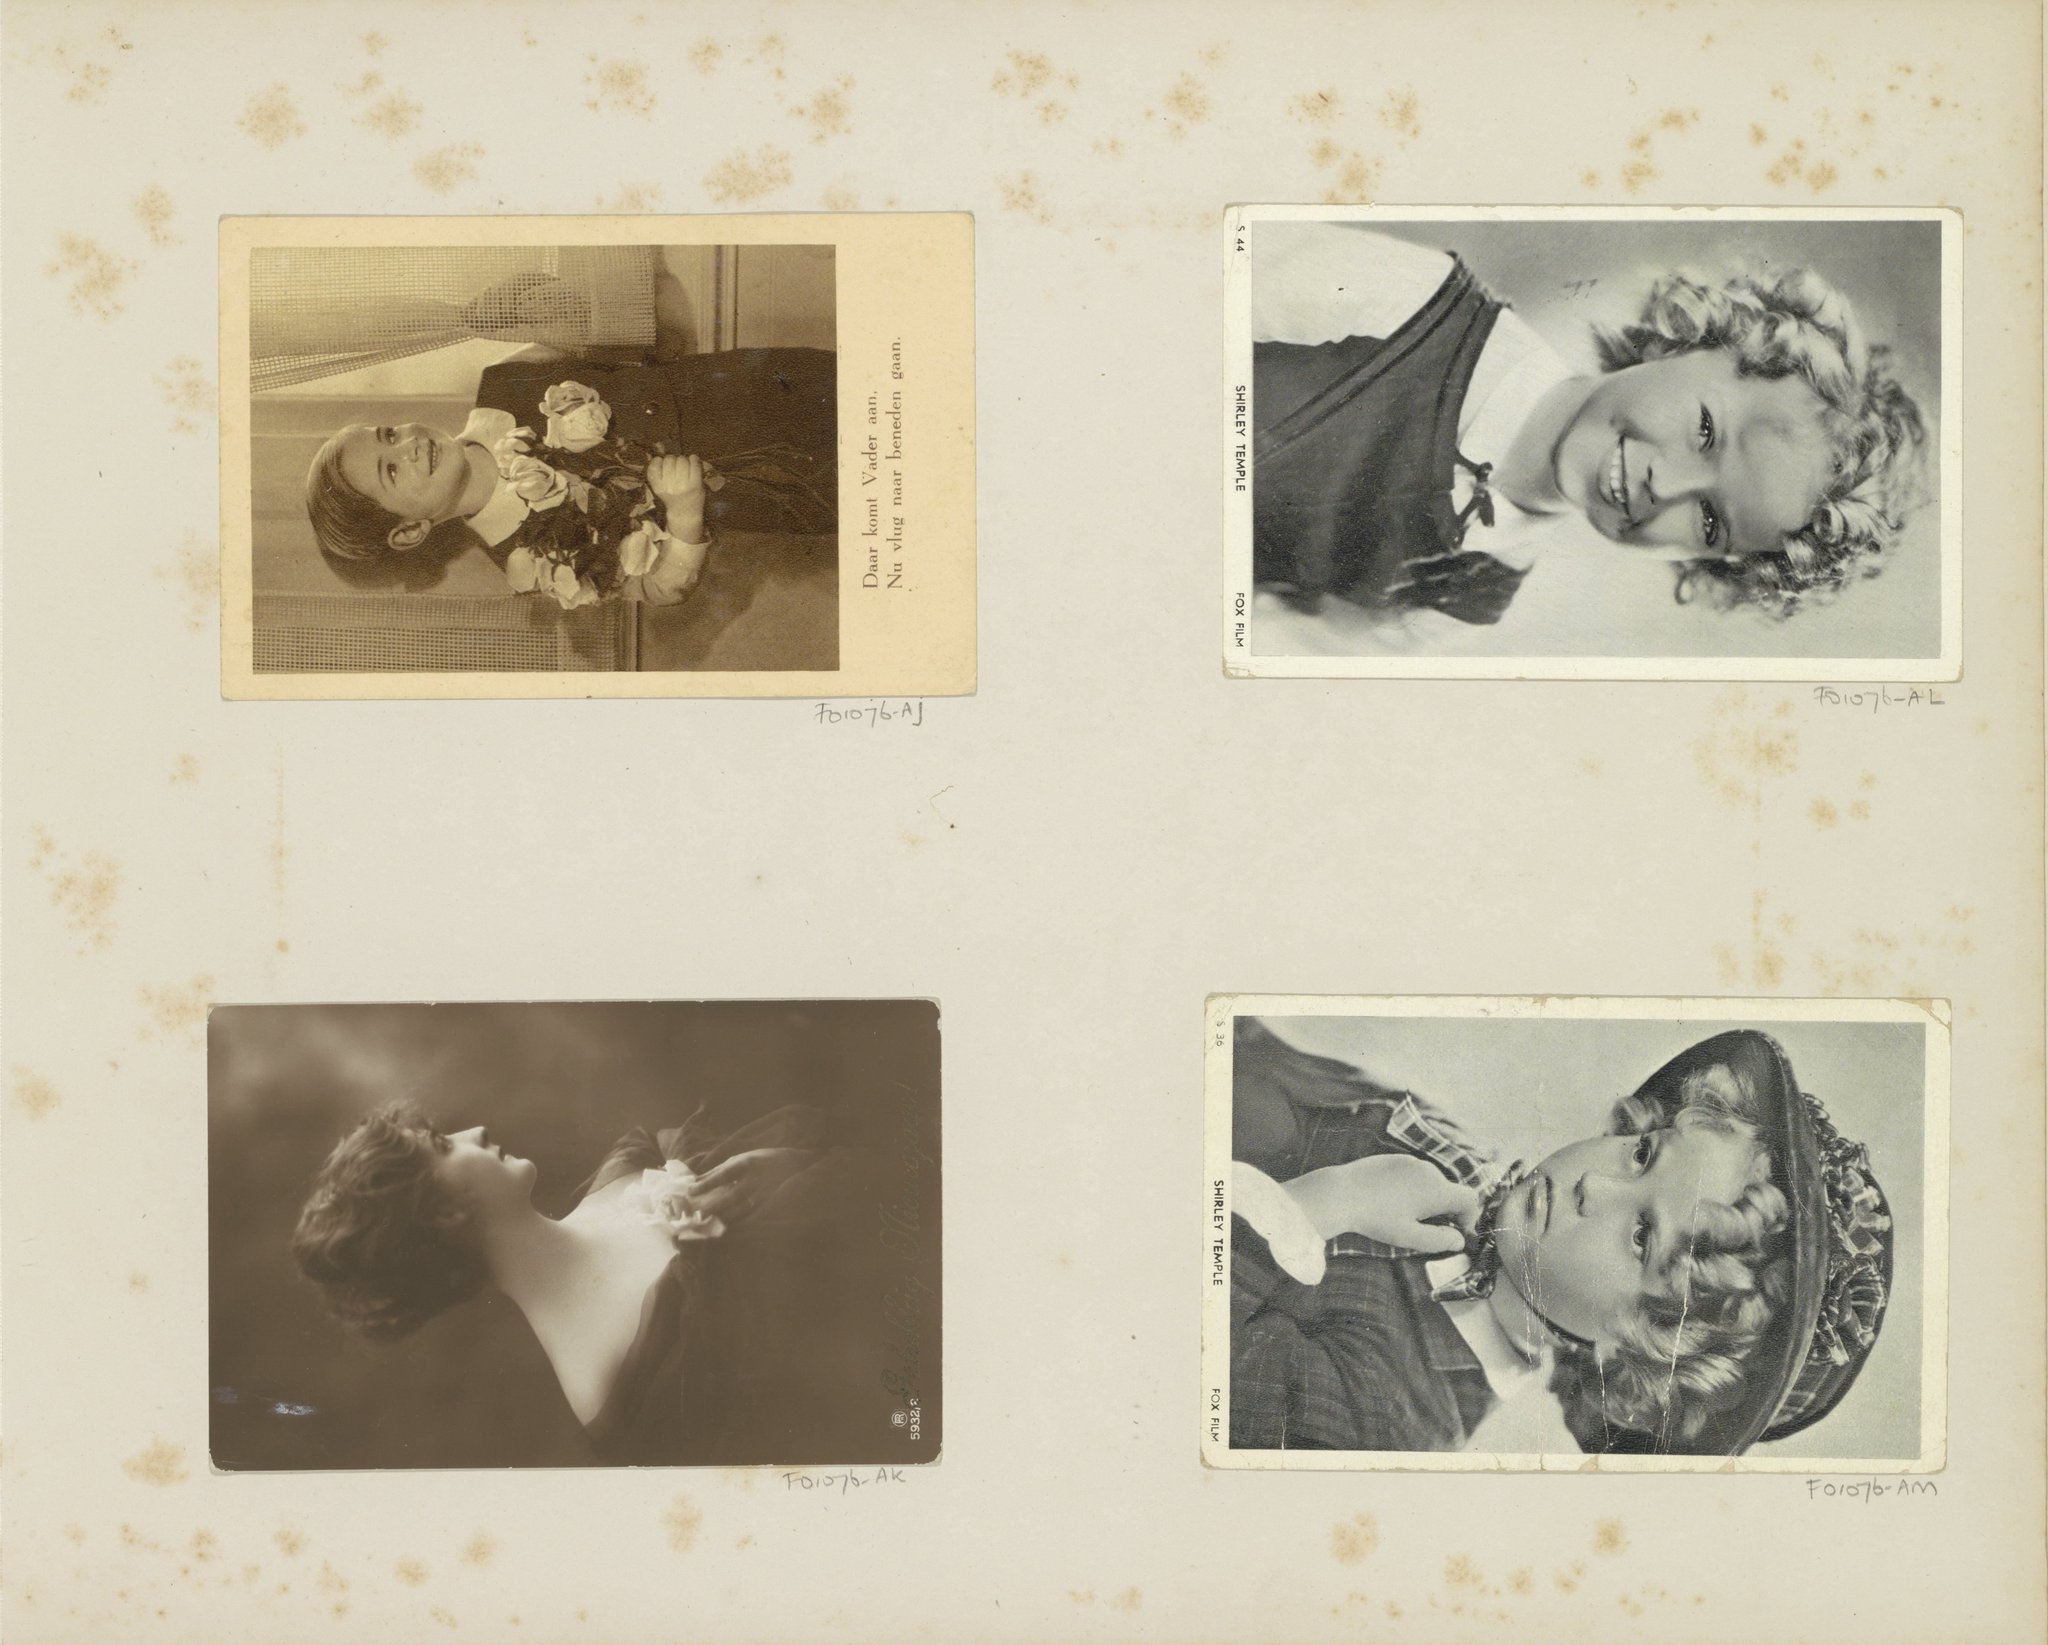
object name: photograph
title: Daar komt Vader aan, Nu vlug naar beneden gaan.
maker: Anonymous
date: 1930-1940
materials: cardboard, paper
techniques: rotogravure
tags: cut flowers; nosegay, bunch of flowers, child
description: Onderdeel van Album met foto's van spoorwegen in Nederlands-Indië en prentbriefkaarten.